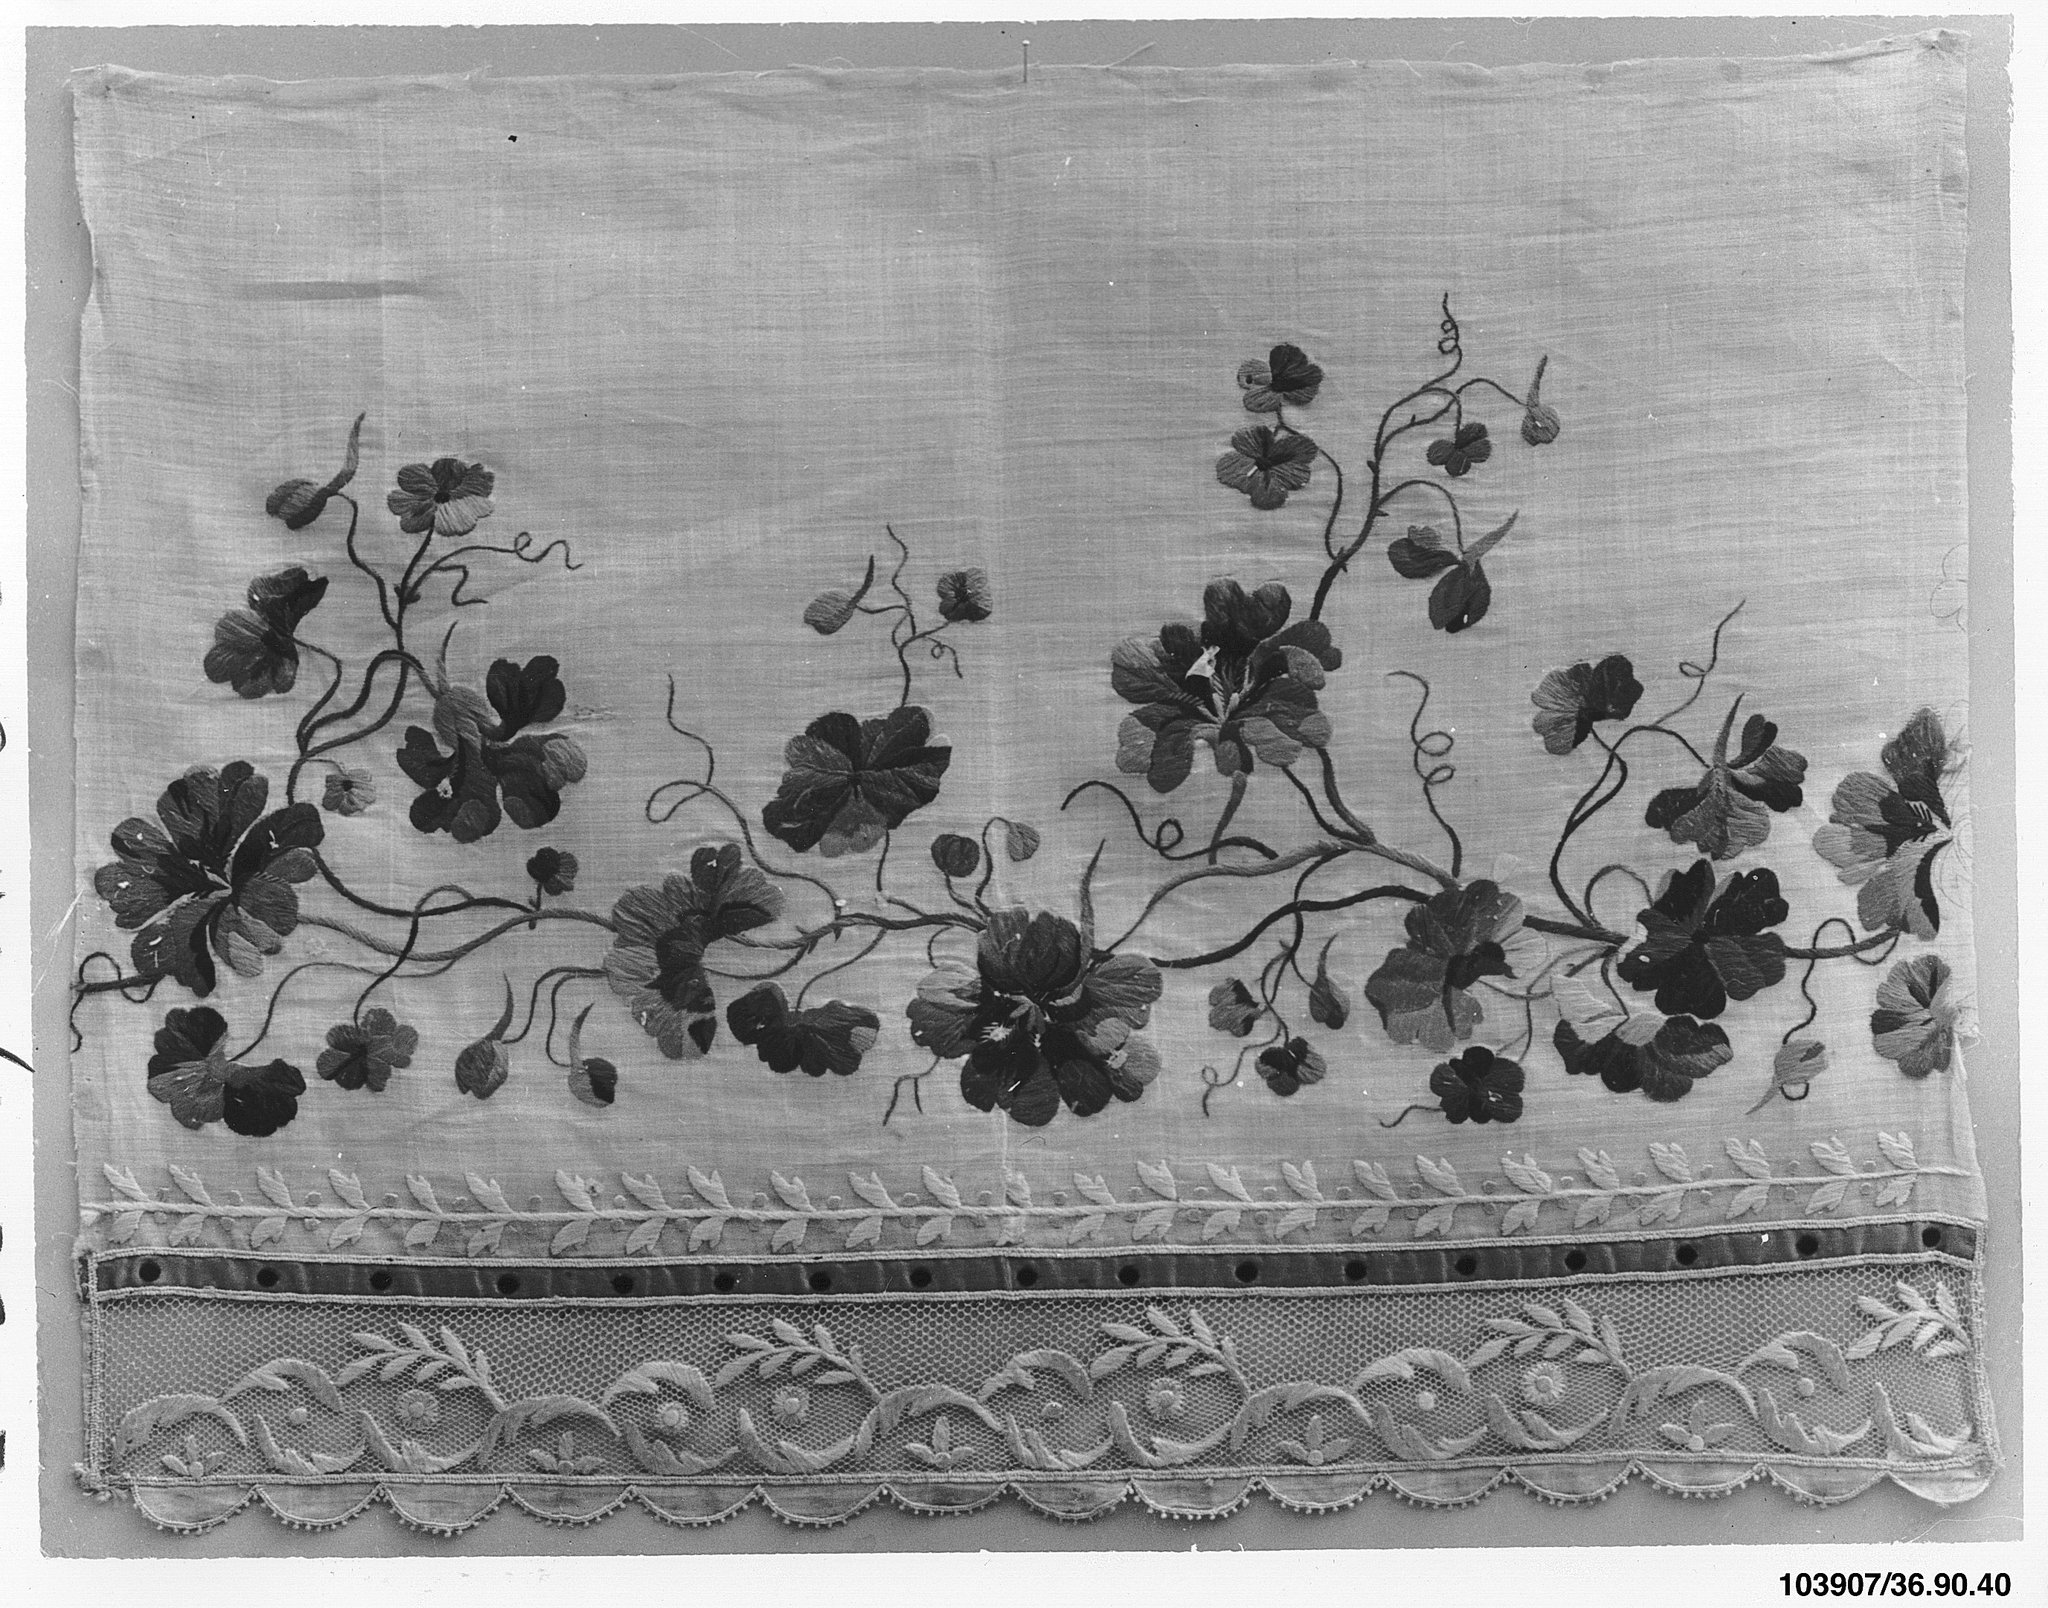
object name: border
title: Dress border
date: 1801-1833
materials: cotton, silk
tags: flowers